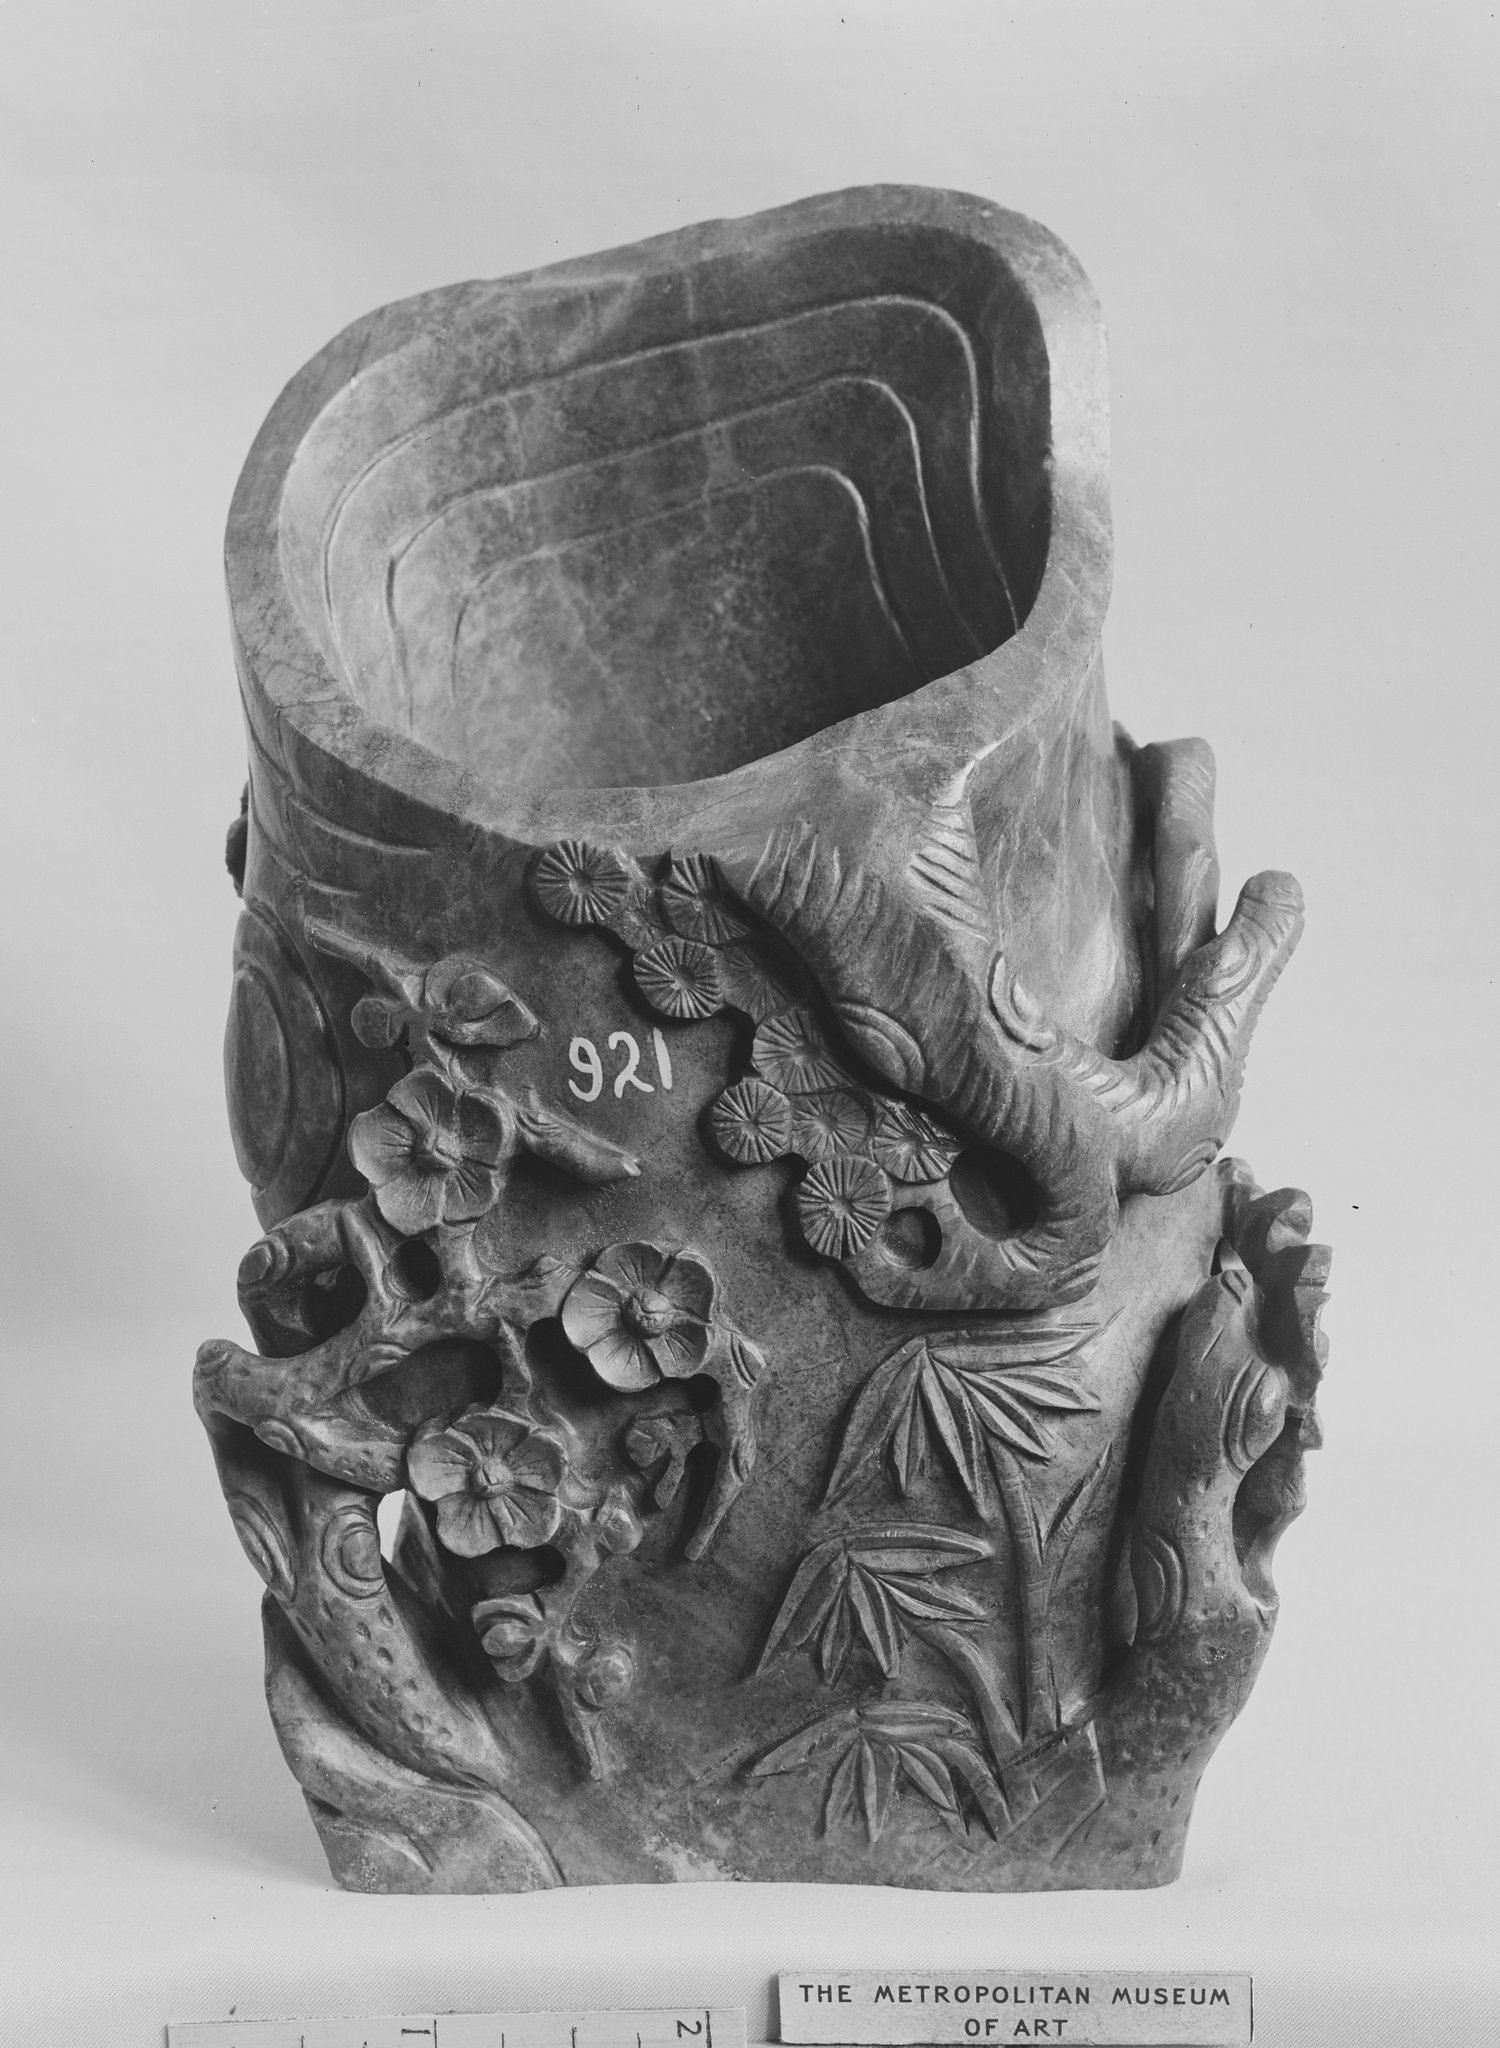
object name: vase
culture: chinese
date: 1701-1800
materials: lapis lazuli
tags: flowers